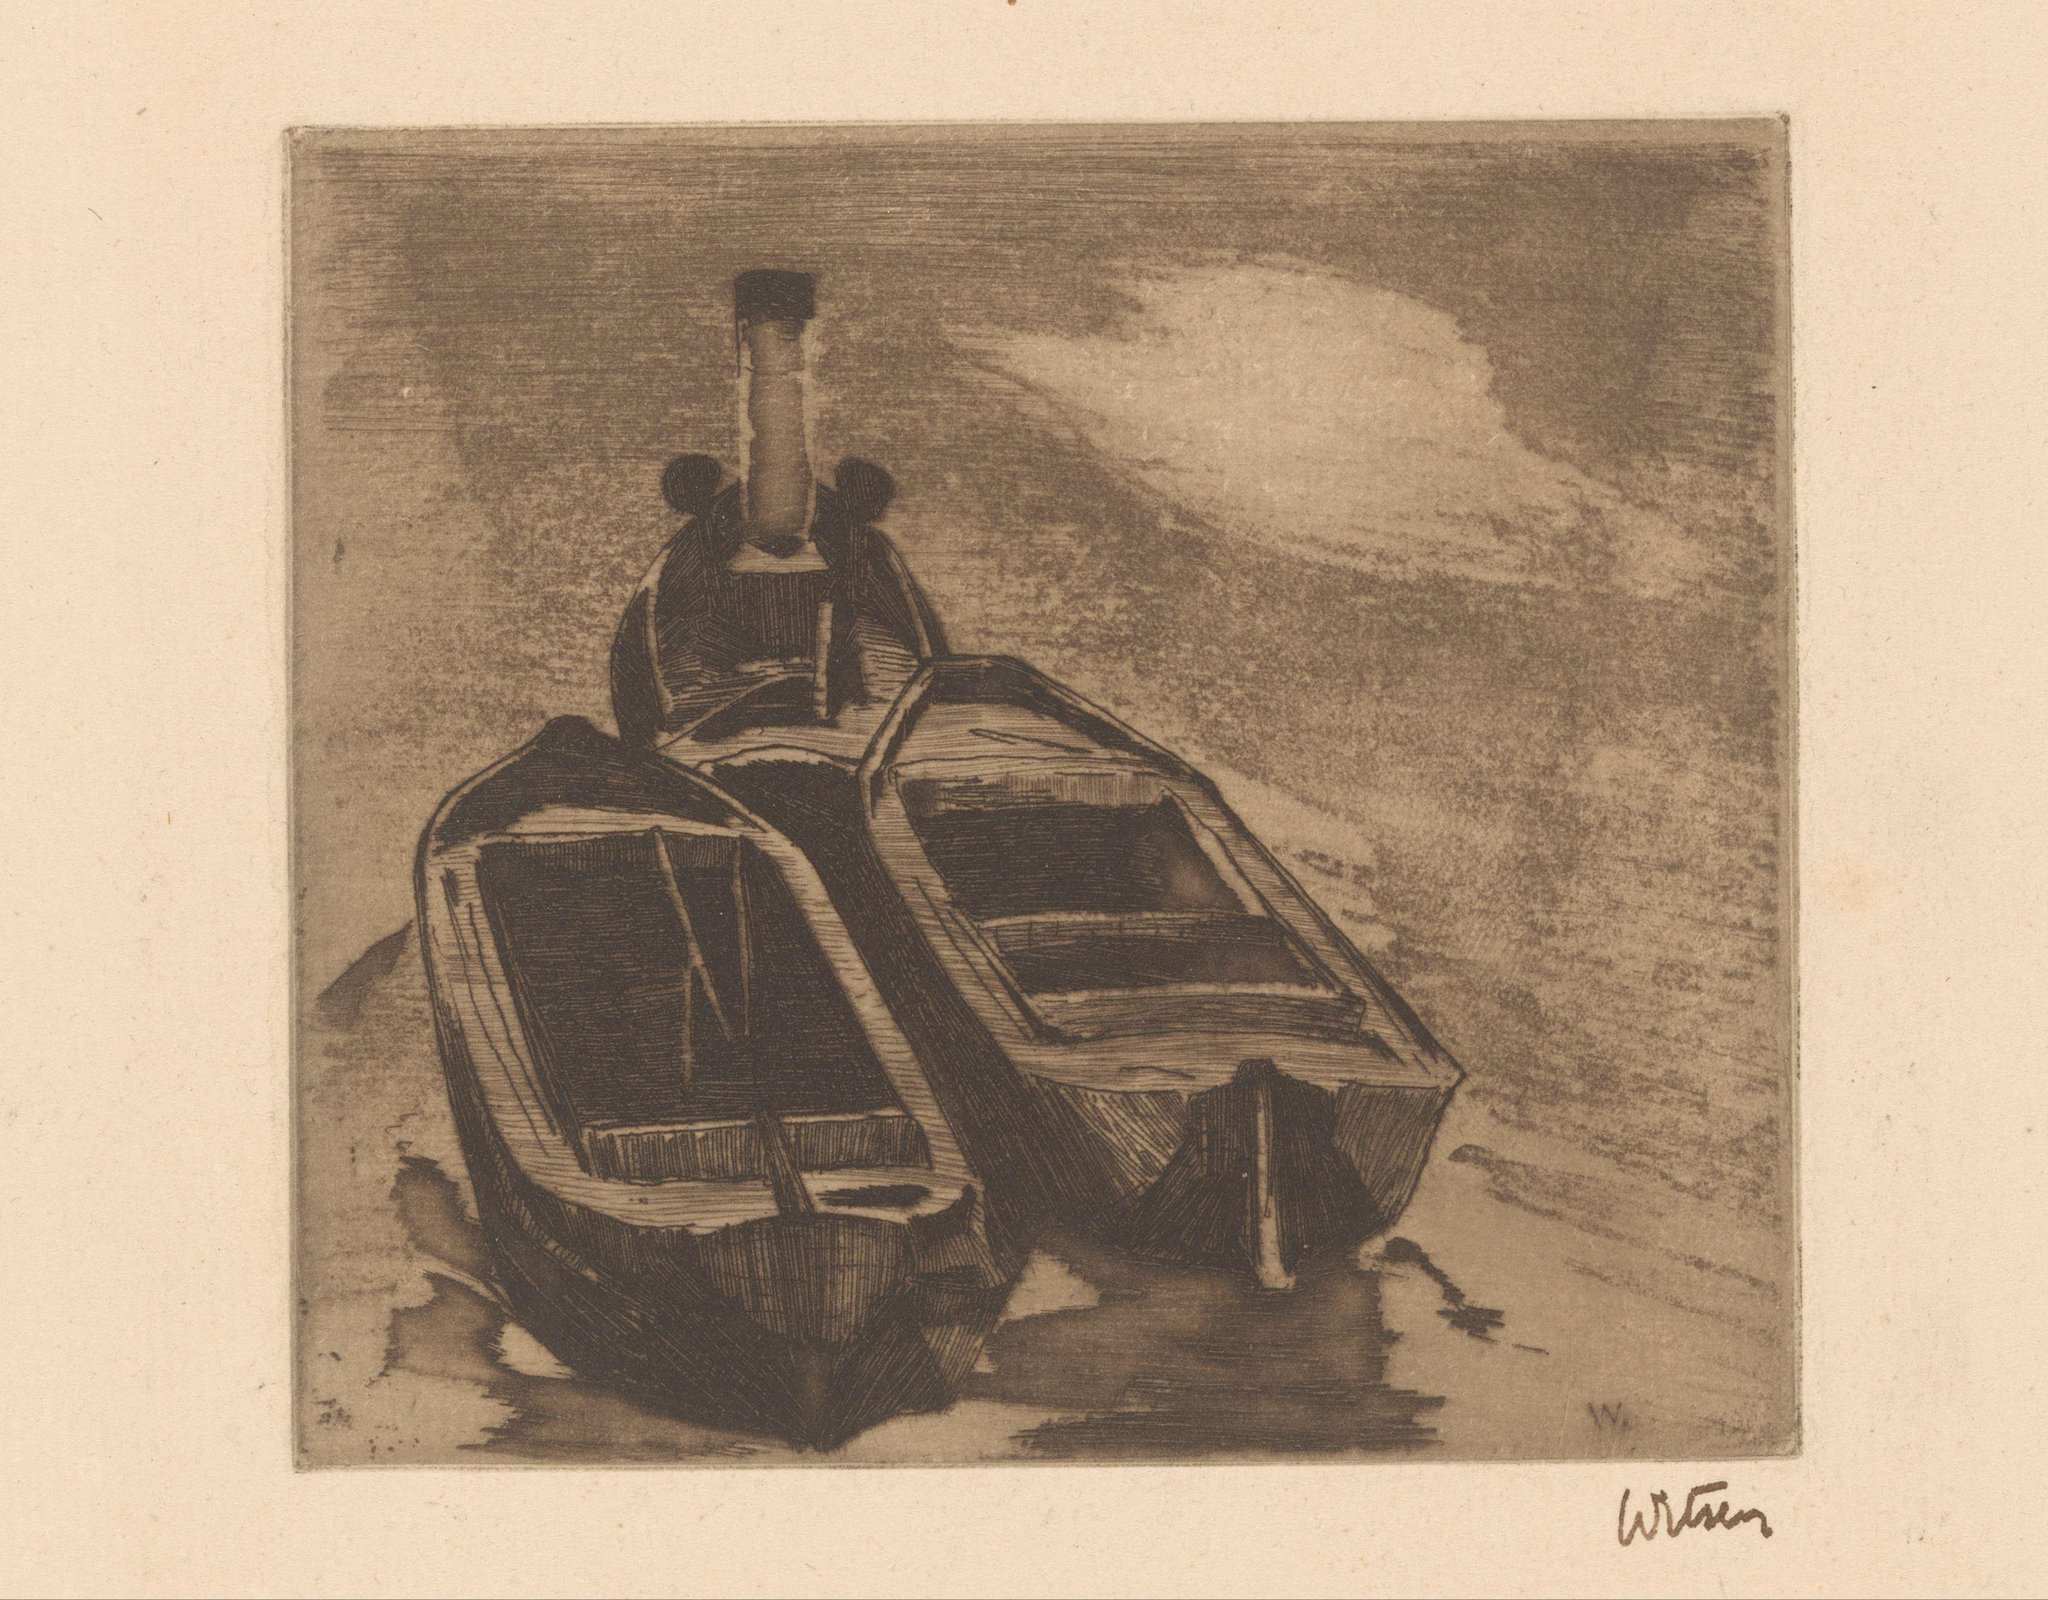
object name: print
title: Sleepboot met twee schuiten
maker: willem witsen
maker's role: draughtsman, painter, print maker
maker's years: 1860-1923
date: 1890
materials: paper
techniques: aquatint, etching, intaglio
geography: london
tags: tow-boat, towing-barge, tug, pusher tug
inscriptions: collector's mark: Lugt 2228, signature: ‘Witsen’